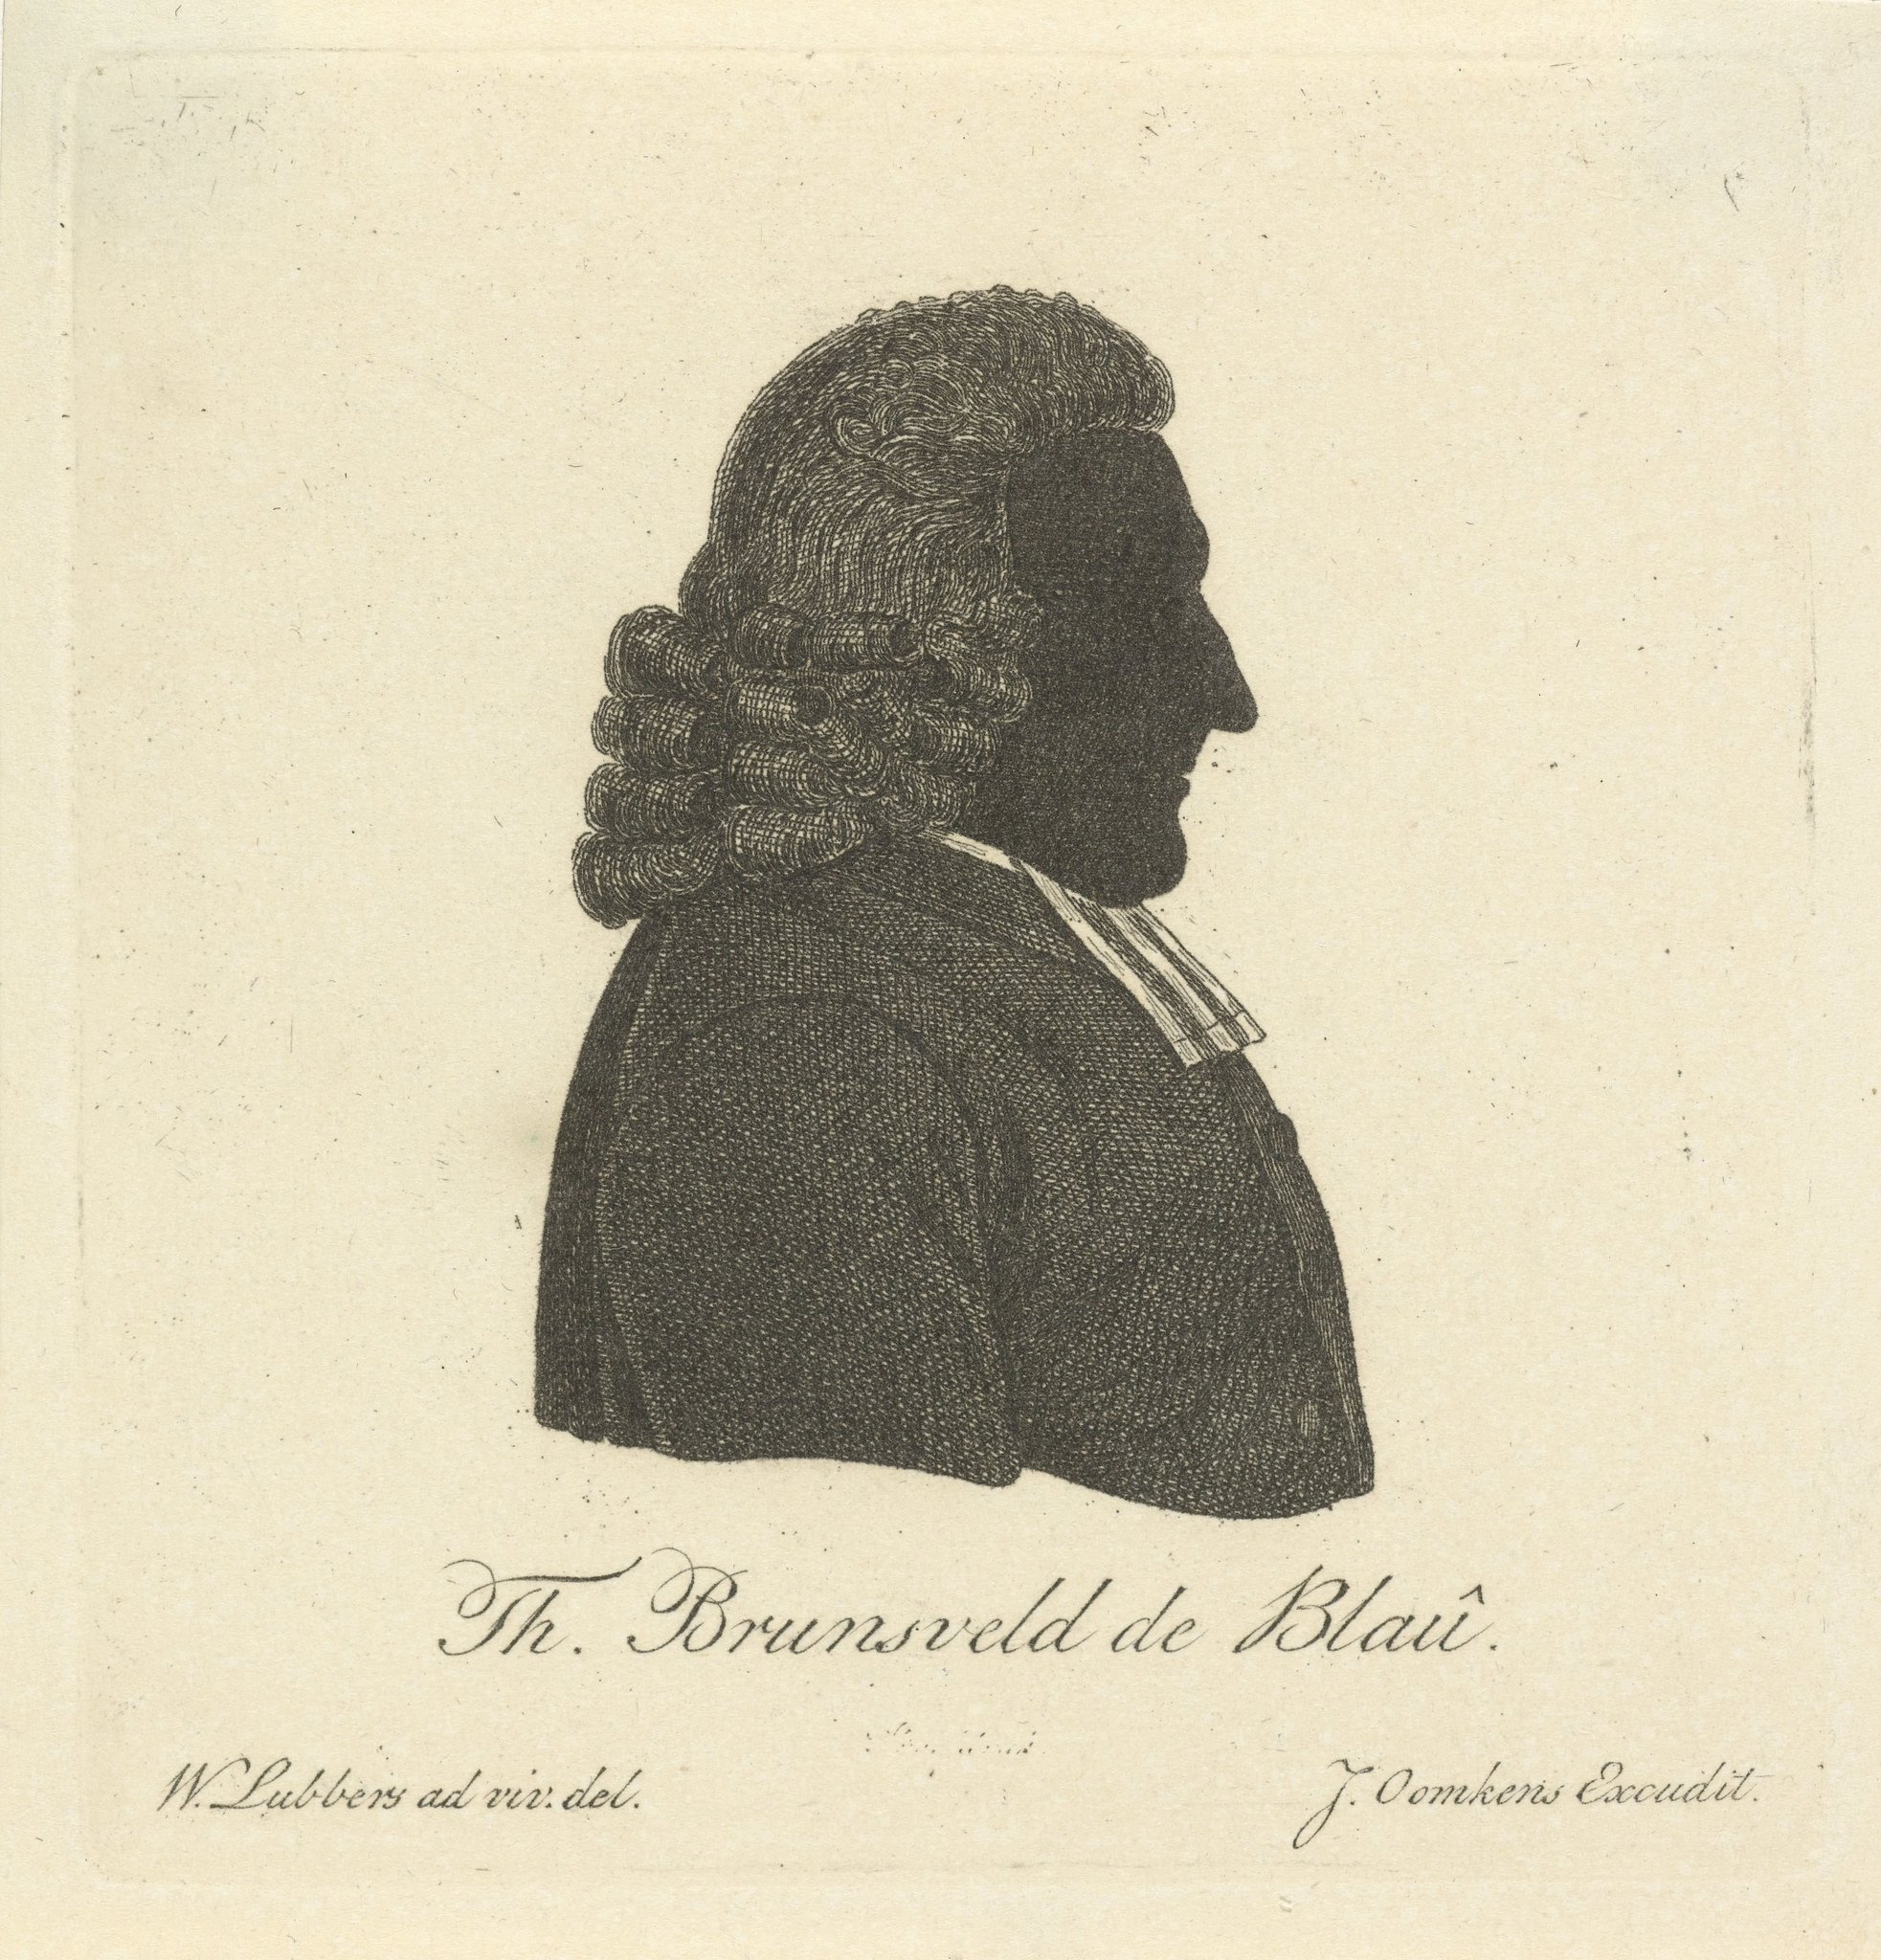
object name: print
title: Silhouetportret van Theodorus Brunsveld de Blau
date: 1808-1844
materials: paper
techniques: etching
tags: leeuwarden, groningen, predikant, theodorus brunsveld de blau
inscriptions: collector's mark: Lugt 2228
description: Silhouetportret van Theodorus Brunsveld de Blau, buste naar rechts.